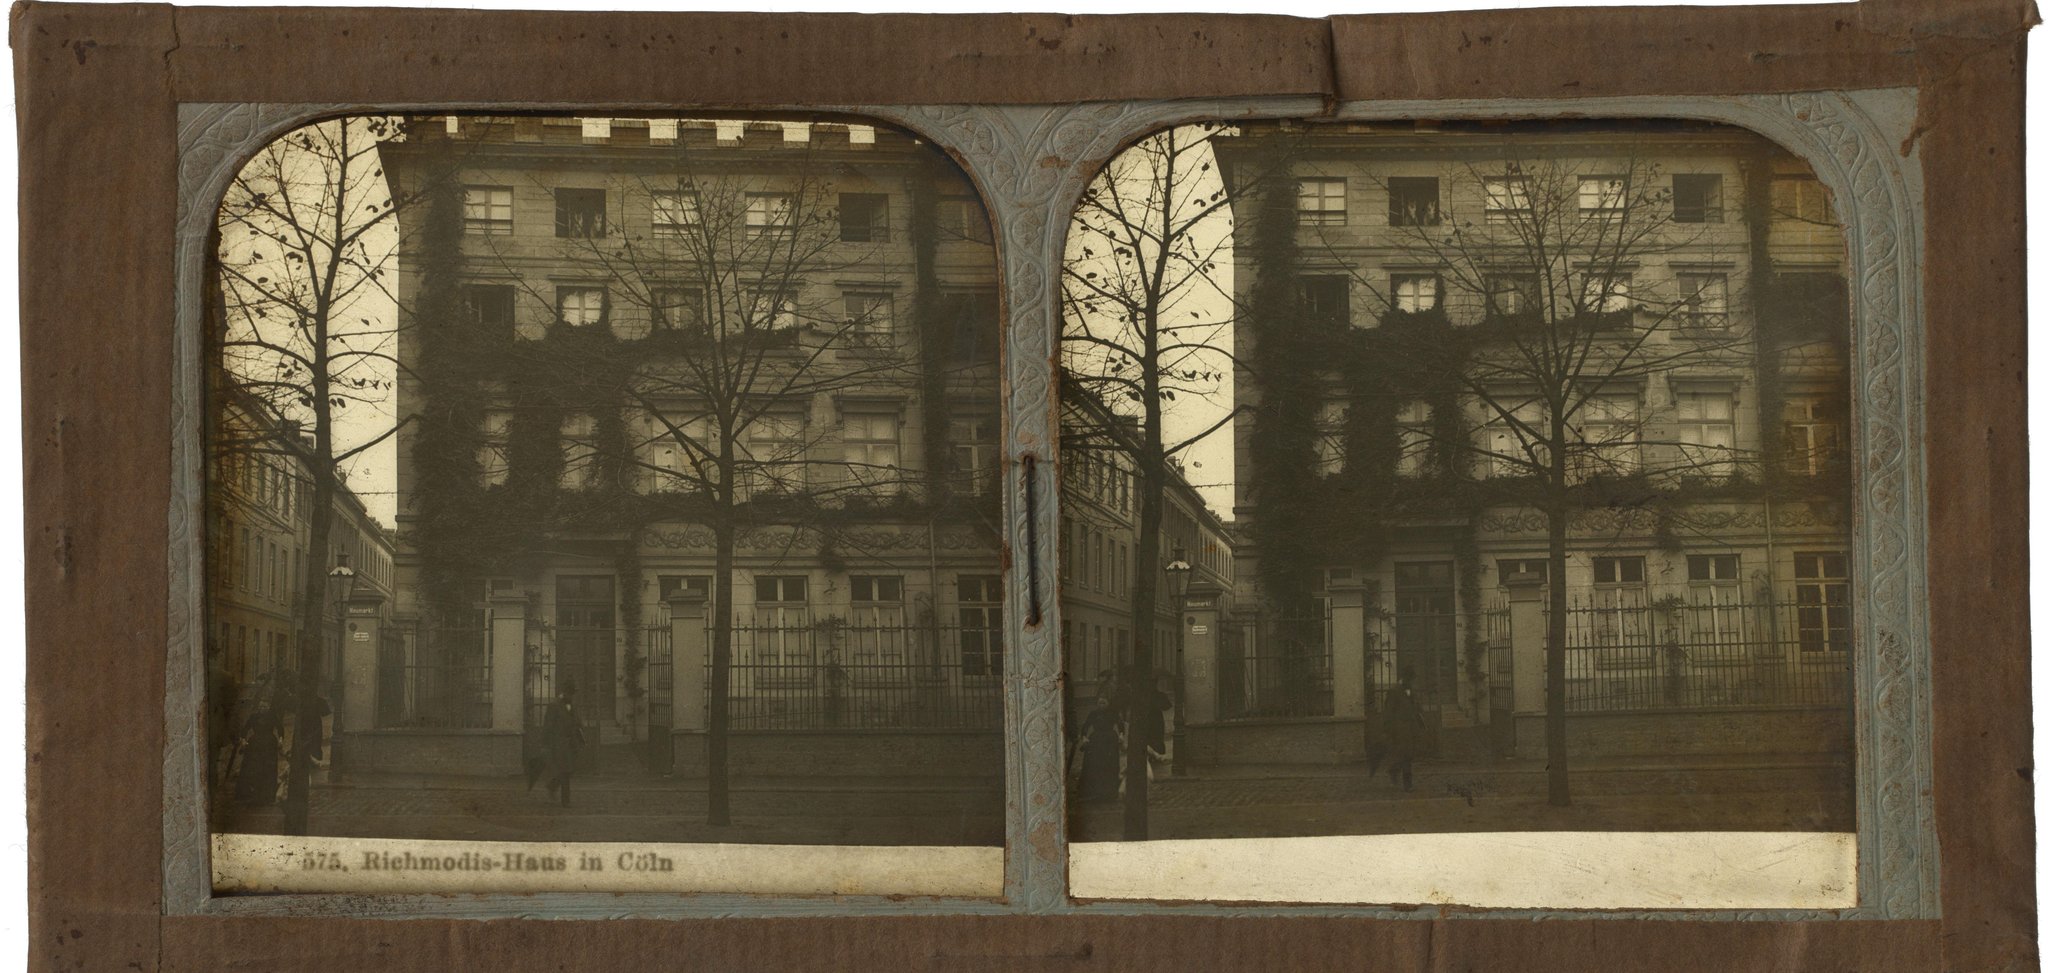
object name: stereograph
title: Deel van de gevel van het Richmodishaus in Keulen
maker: Anonymous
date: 1900-1940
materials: cardboard, film, metal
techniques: gelatin silver print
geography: cologne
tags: façade (of house or building)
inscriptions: number: ‘575.’